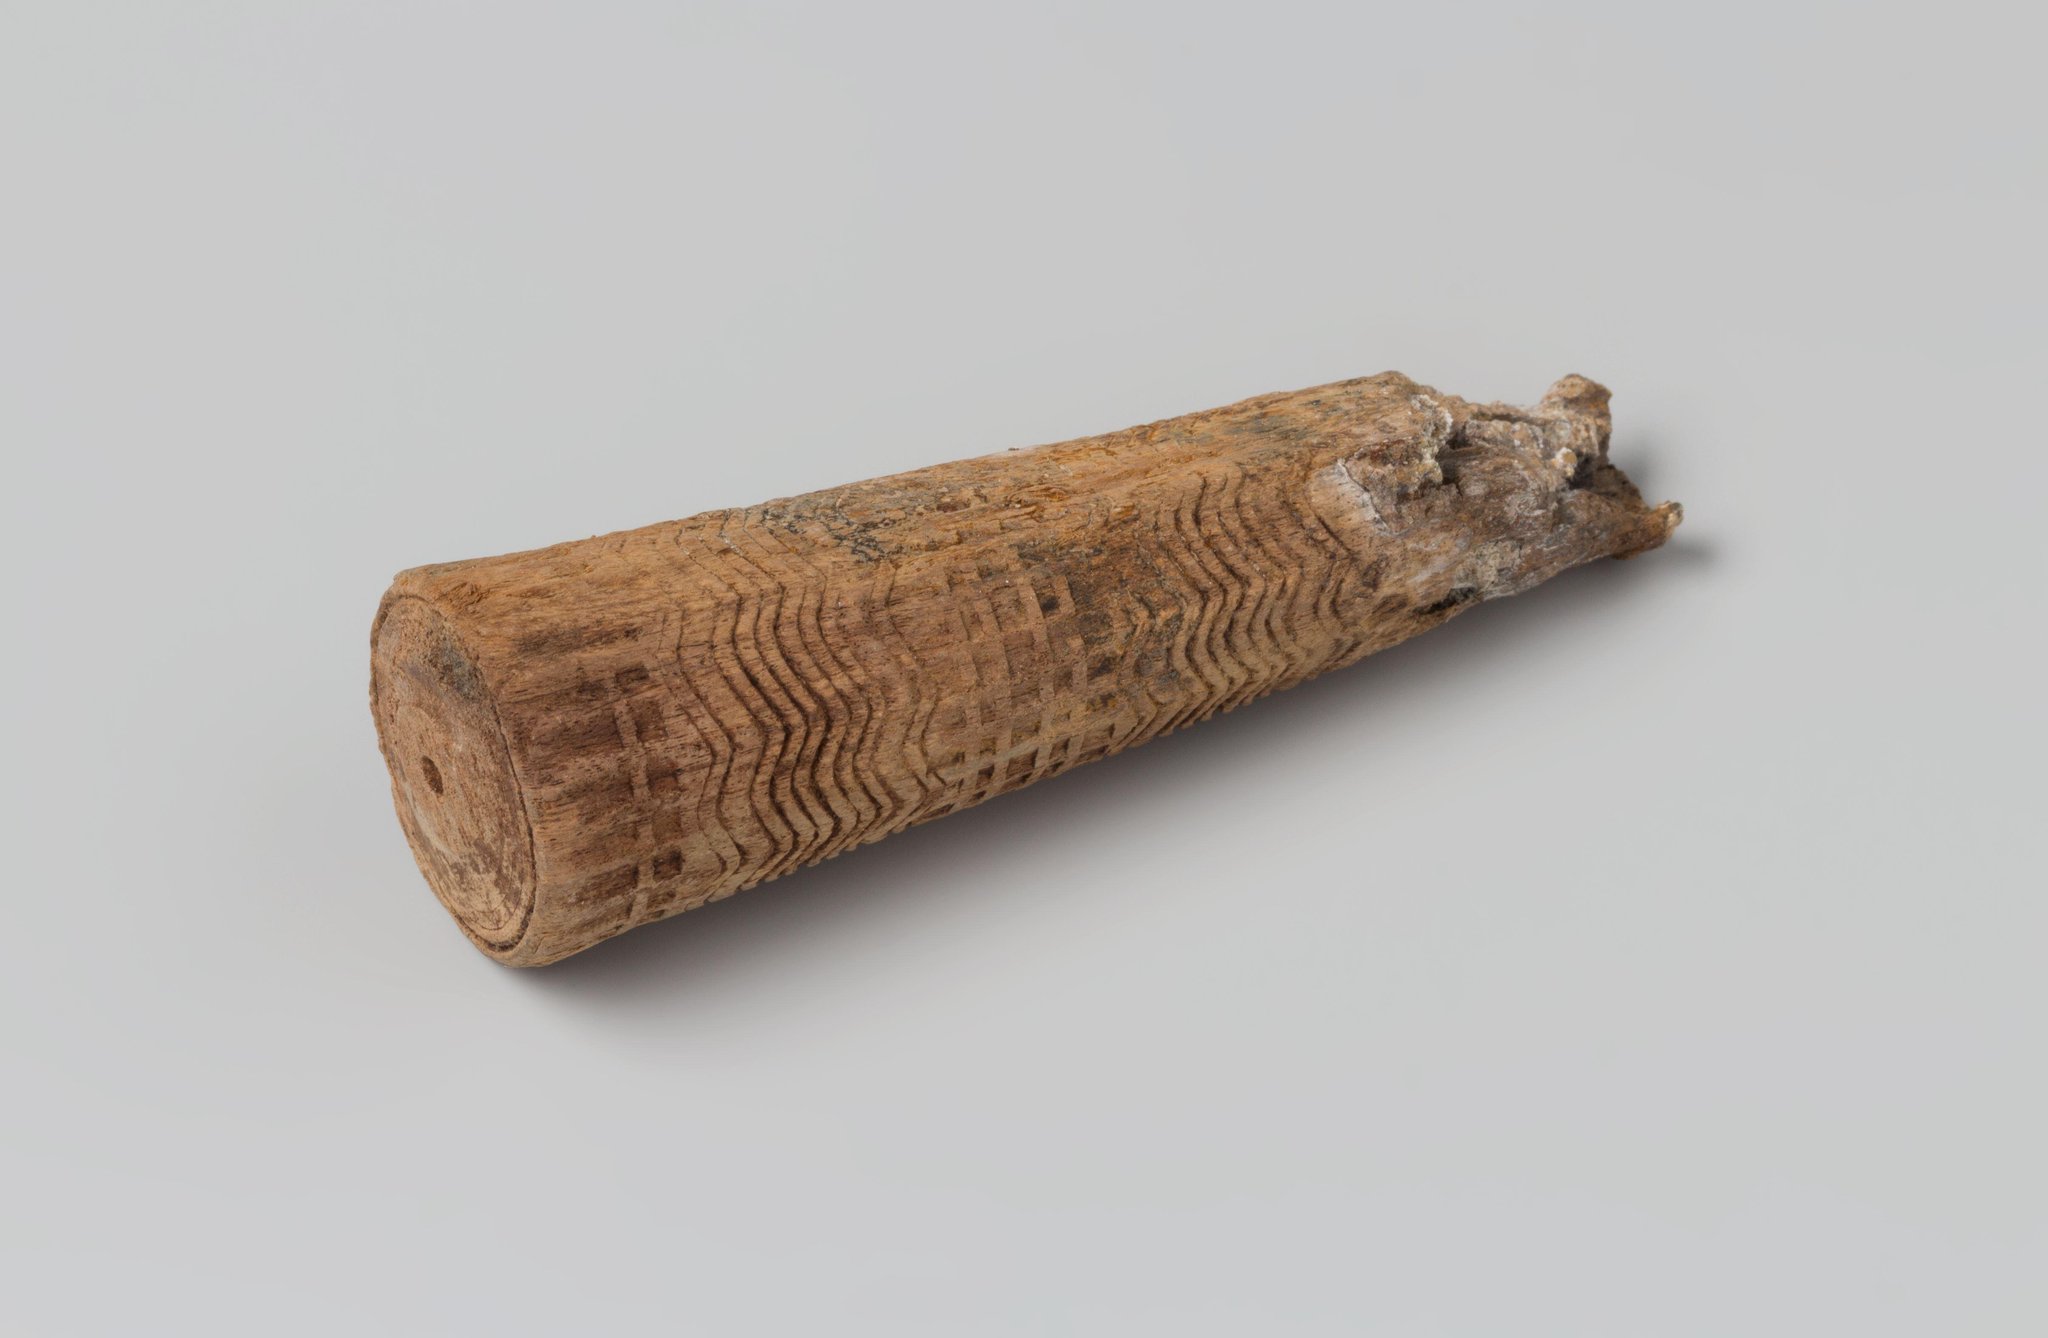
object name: knife handle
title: Messenheft uit het wrak van de Oost-Indiëvaarder Hollandia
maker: Anonymous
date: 1700-1743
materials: wood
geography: netherlands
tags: verenigde oostindische compagnie, hollandia (schip), annet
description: Knife, handle, cylindrical: tapering; id. NG 1979-403H.